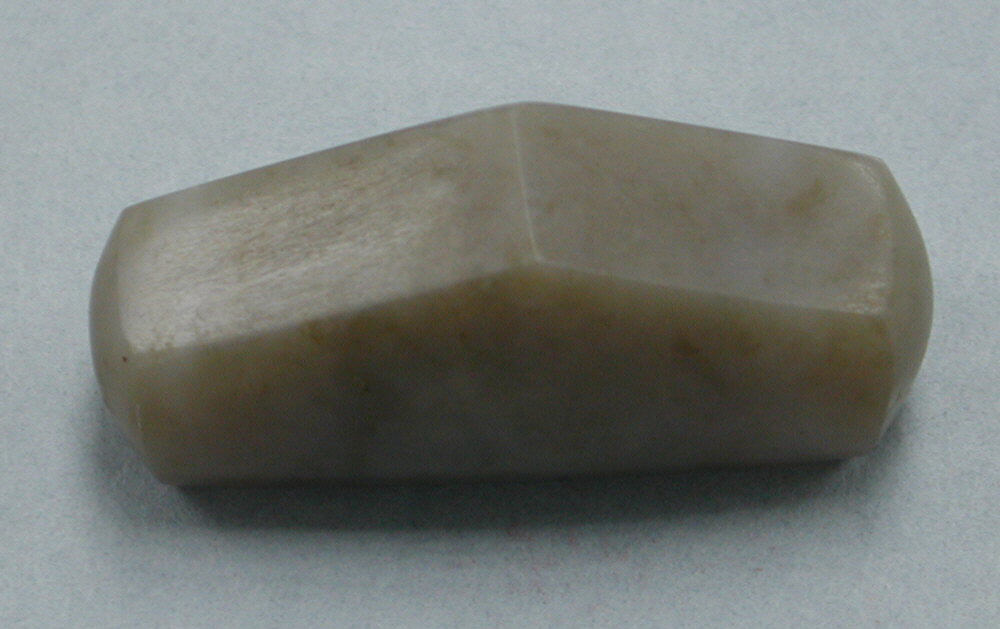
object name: ritual stone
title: Polishing Stone (pulidor)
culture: mexican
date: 1501-1600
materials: stone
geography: mexico